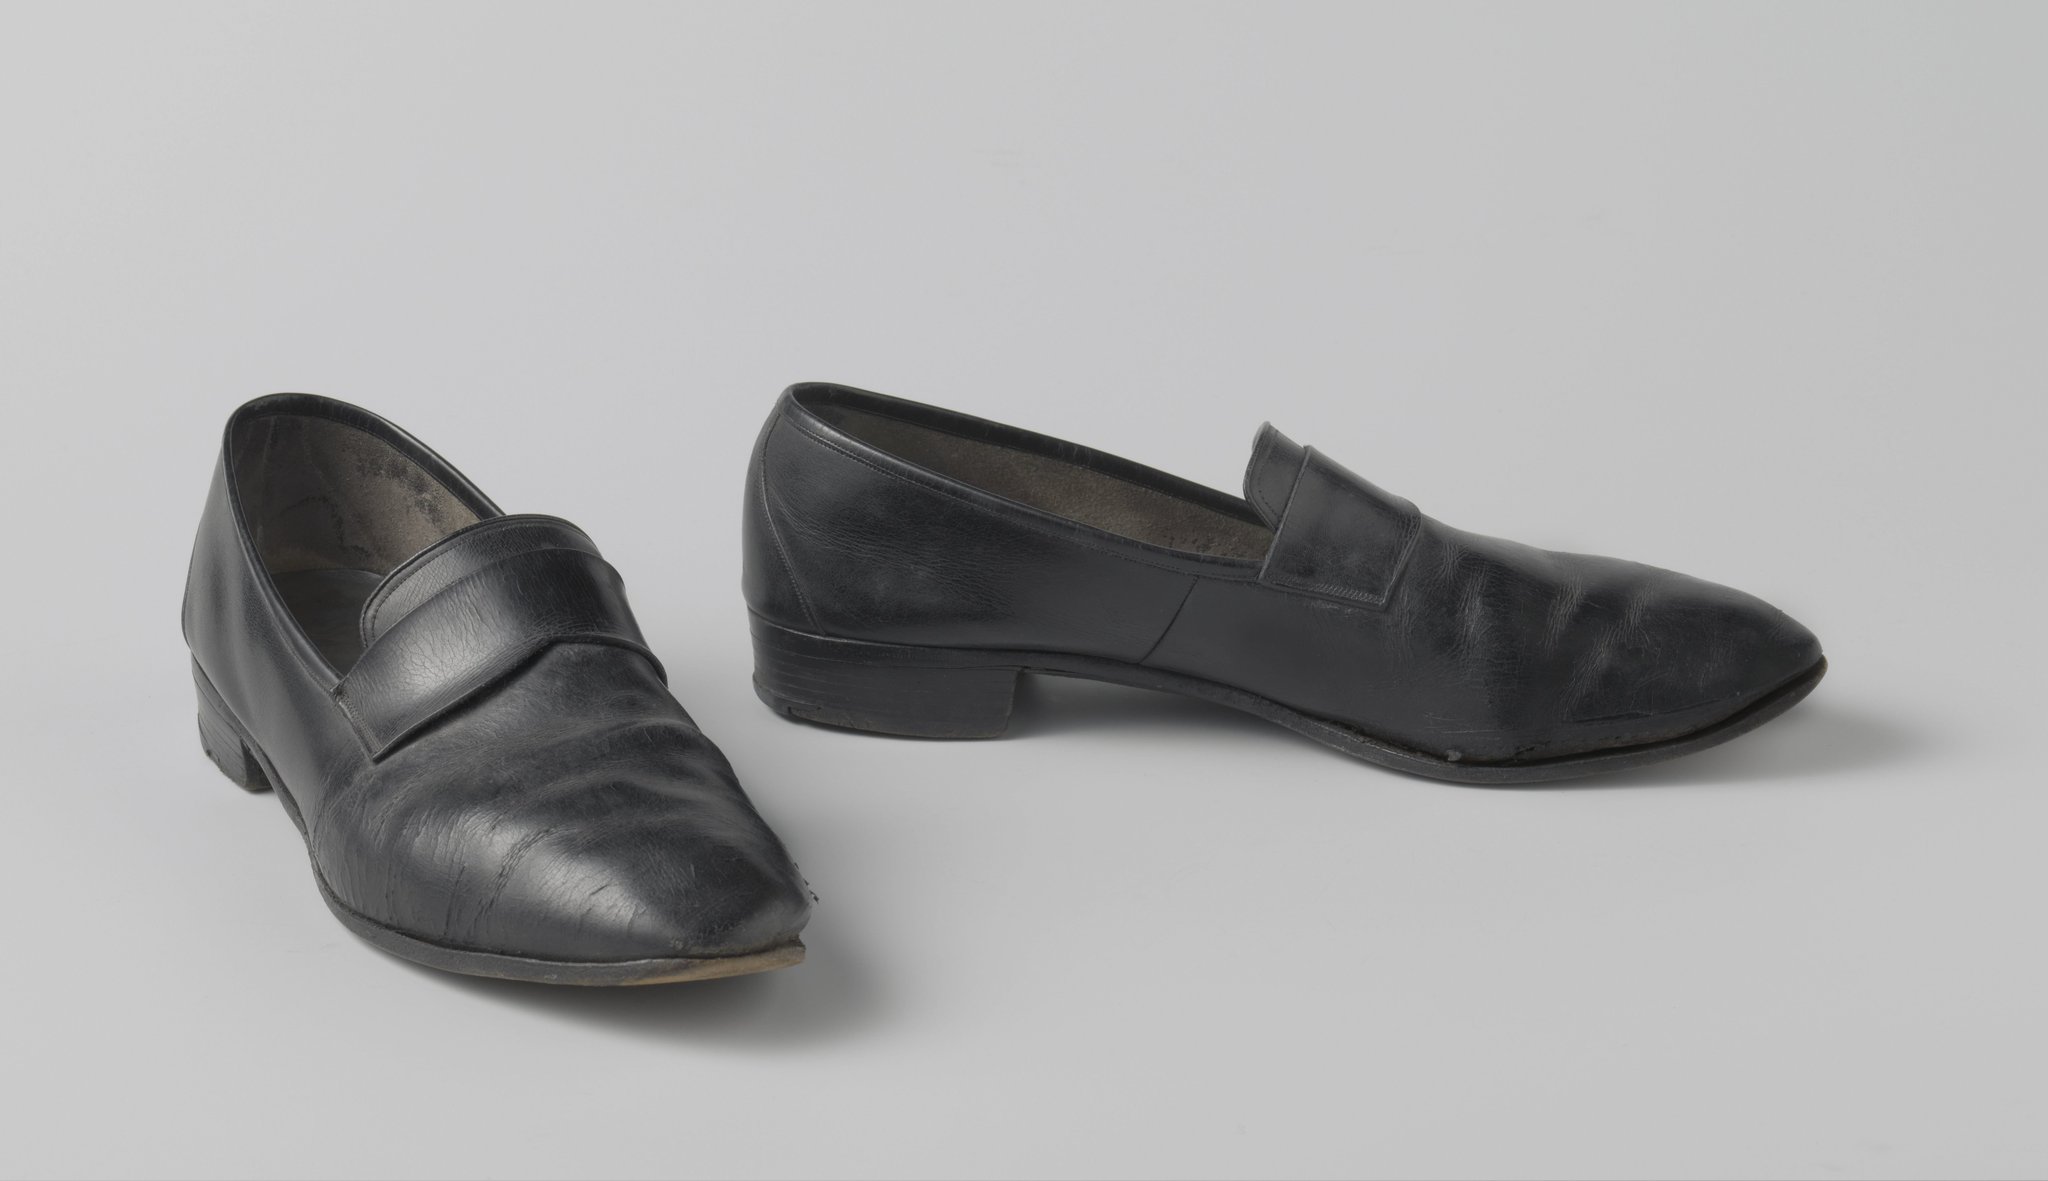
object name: menswear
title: Schoen van zwart leer, laag model, hoog voorblad met vaste wreefbanden en met afgeronde puntneus en lage hak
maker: Anonymous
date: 1915-1925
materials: leather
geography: netherlands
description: Rechterschoen van zwart leer. Laag model, hoog voorblad, als tong iets uitkomend onder vaste wreefbanden. Puntneus, maar afgerond. Lage hak.